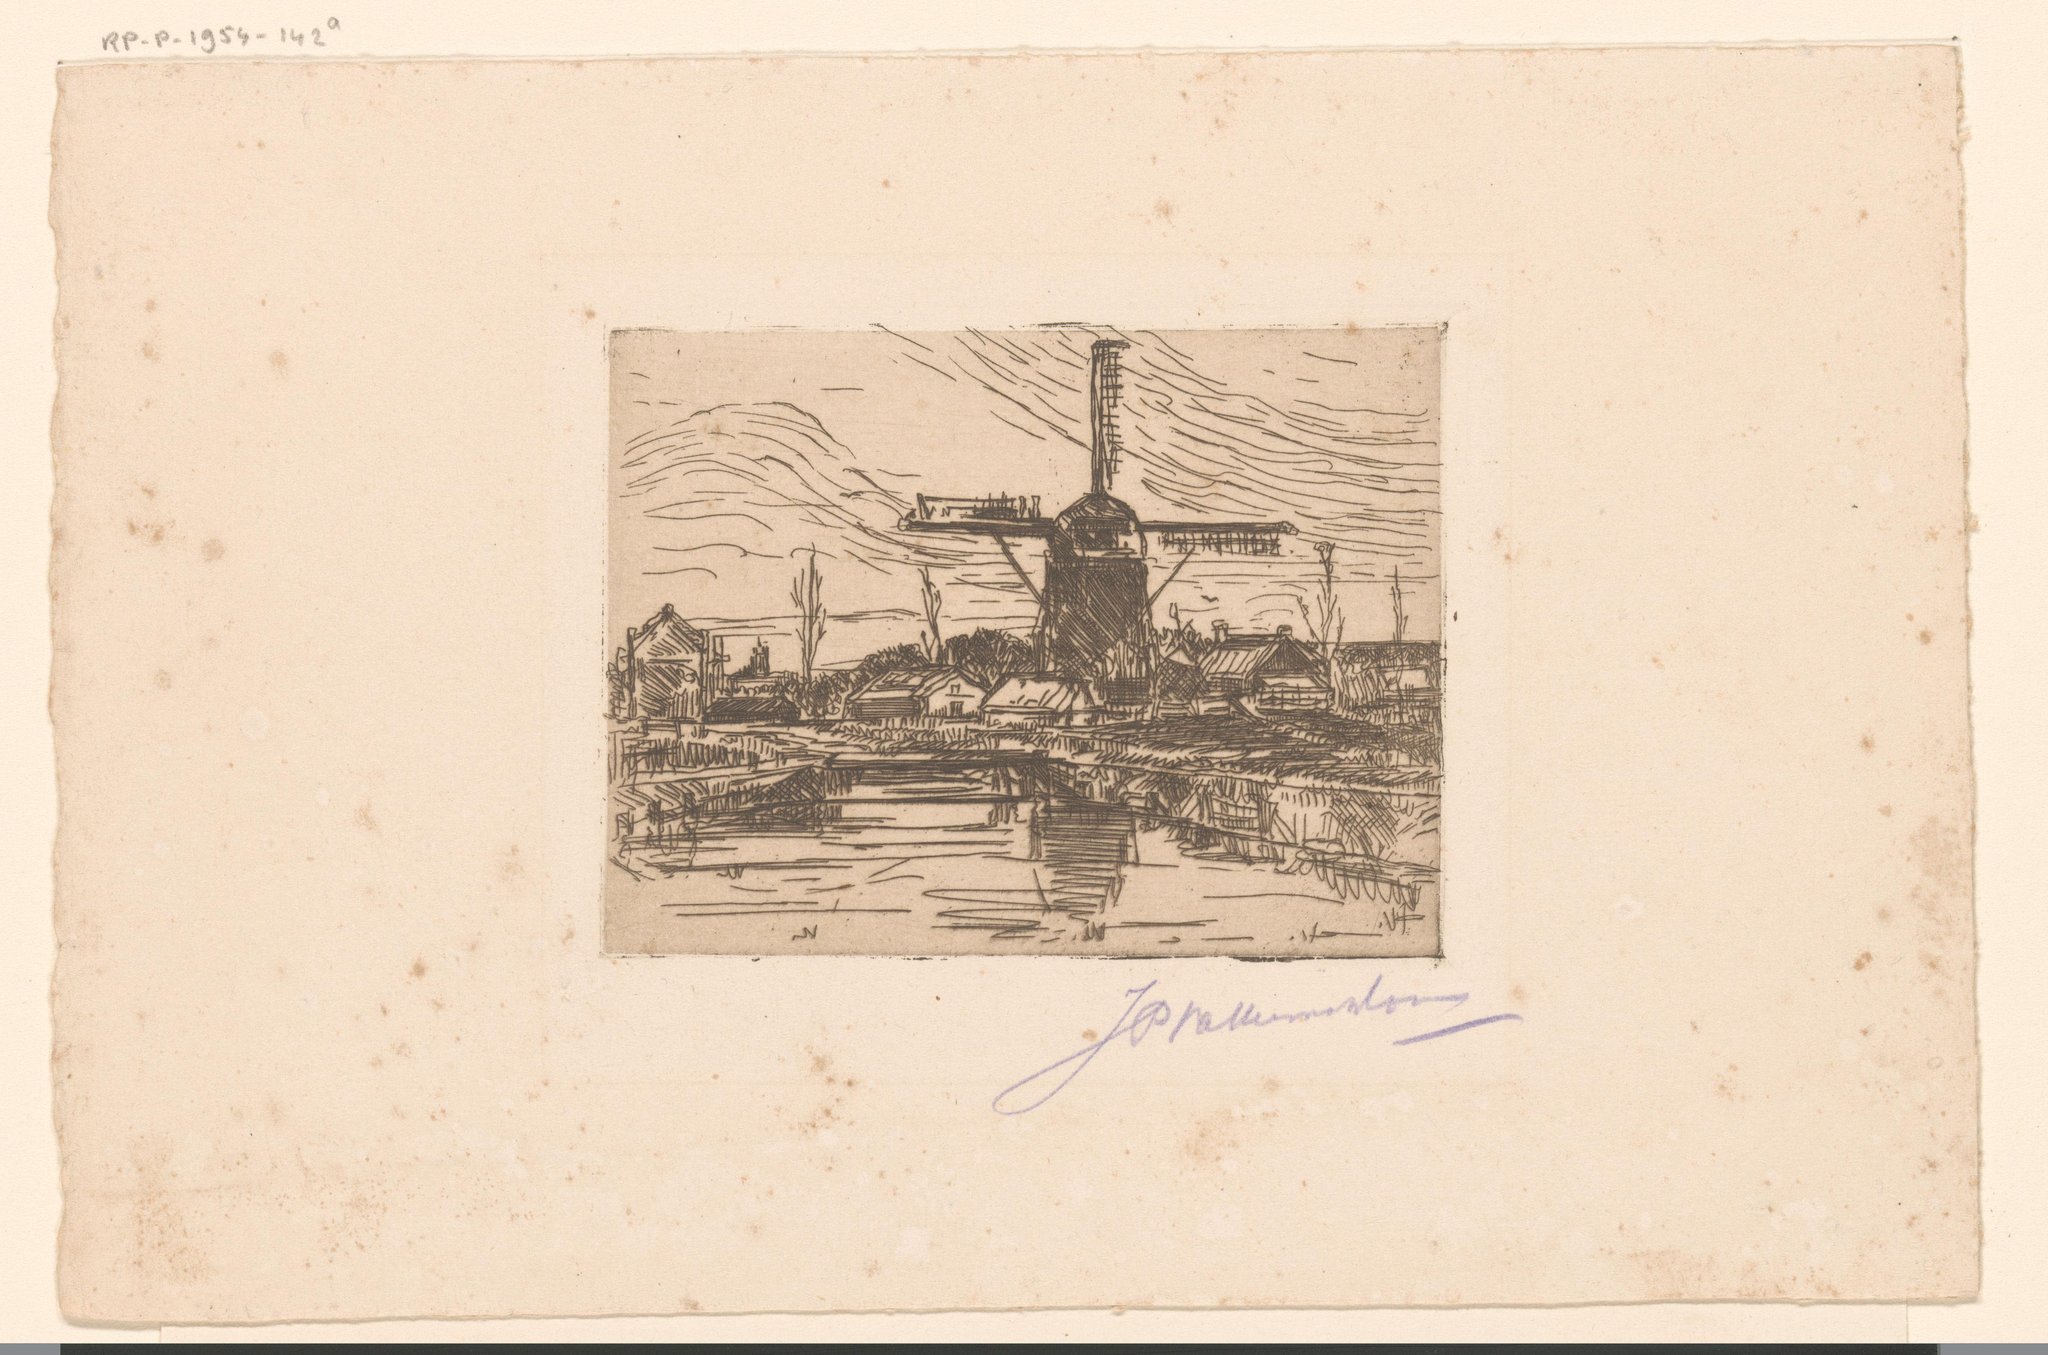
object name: print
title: Vaart met huizen en molen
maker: jan paul valkema blouw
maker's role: draughtsman, print maker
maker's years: 1884-1954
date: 1916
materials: paper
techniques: etching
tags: canal, windmill in landscape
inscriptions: collector's mark: Lugt 2228, collector's mark: Lugt 2760